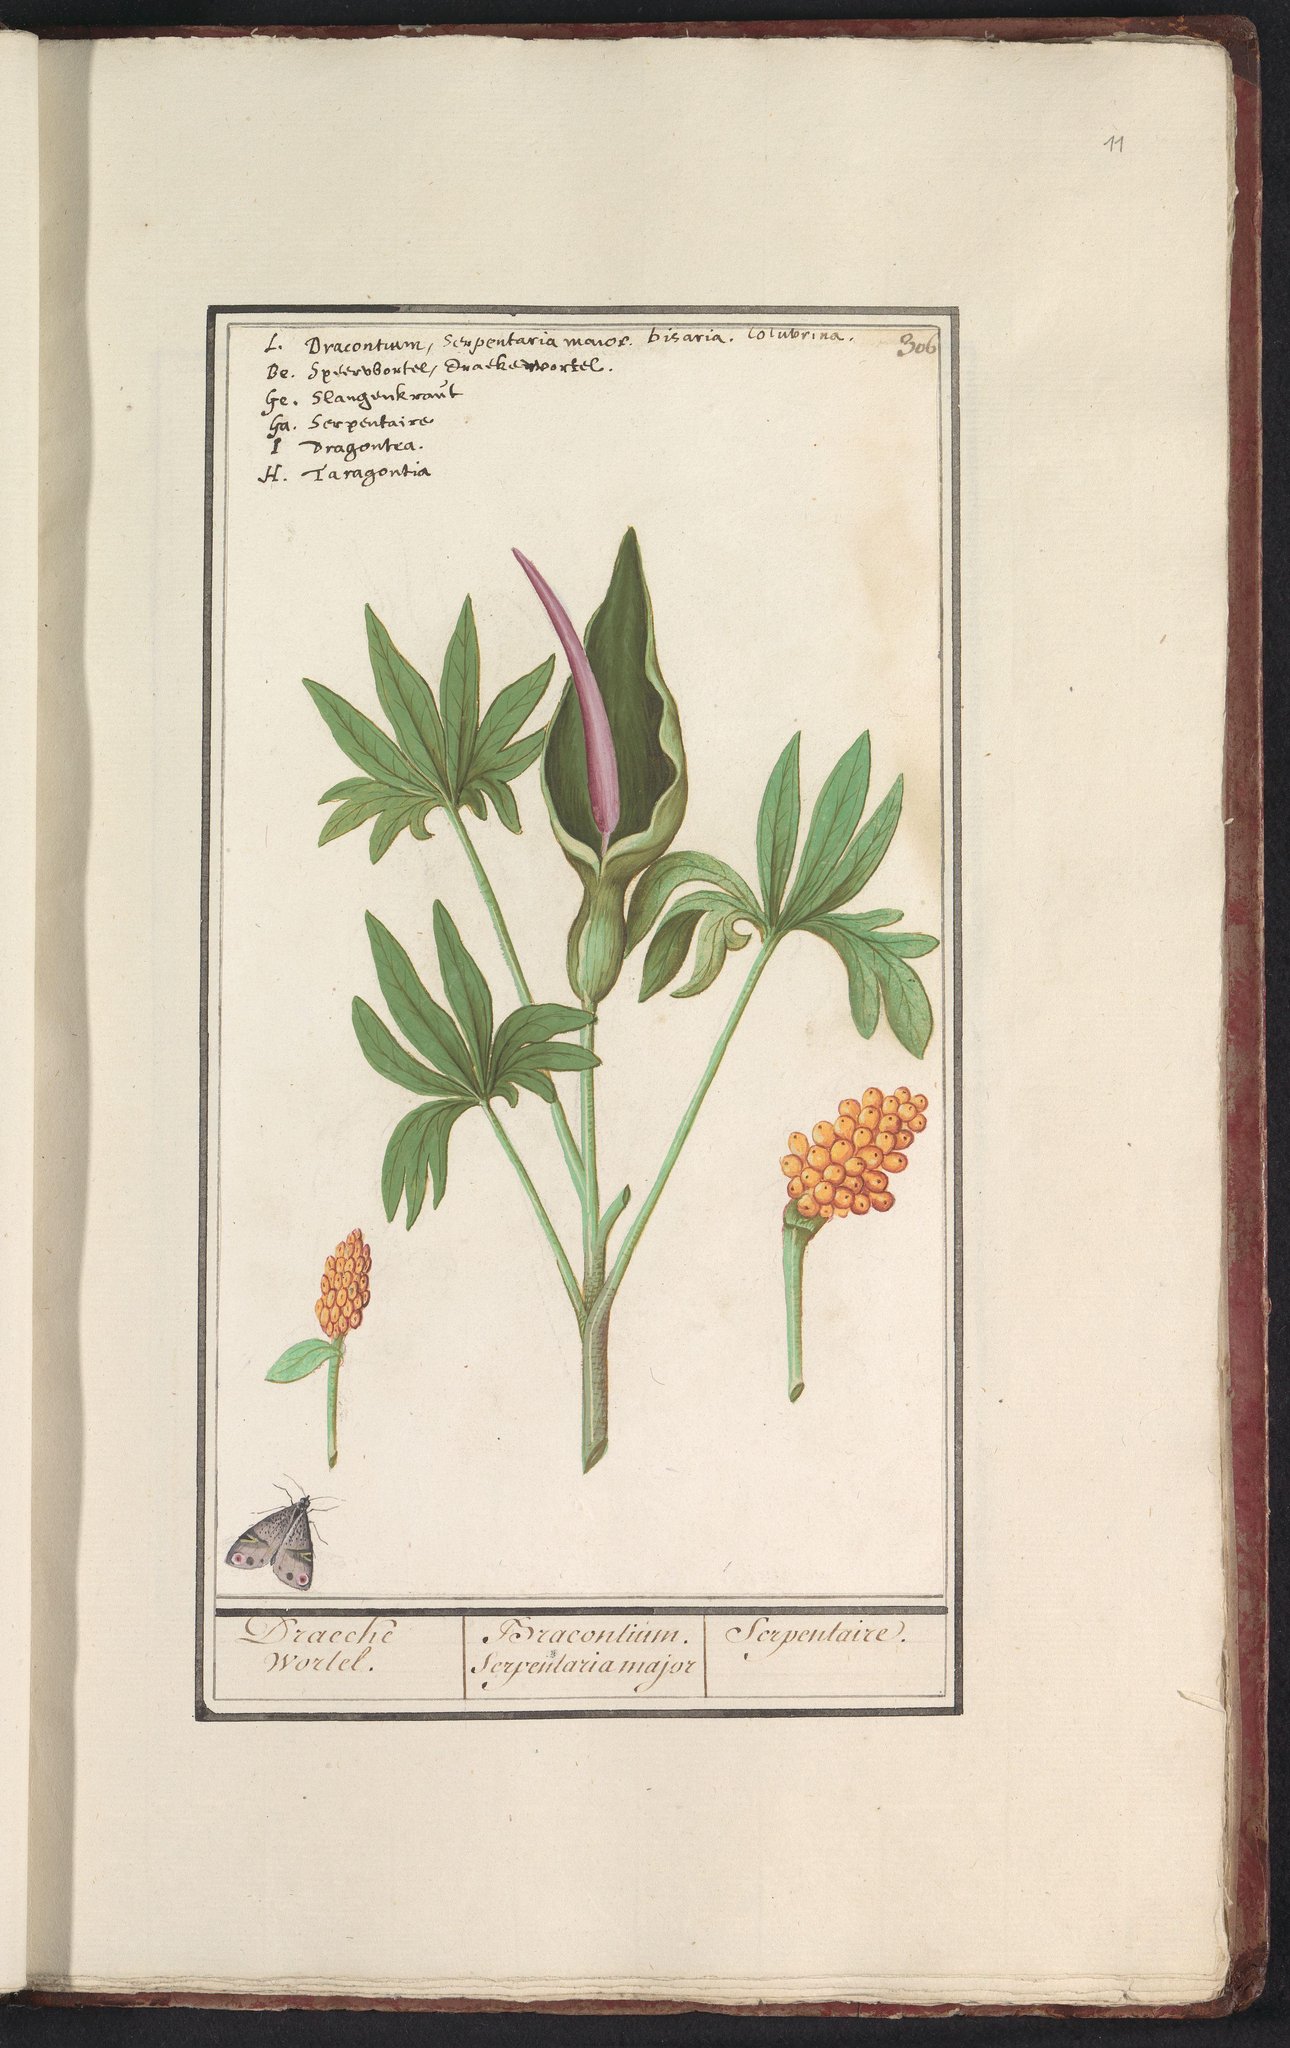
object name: drawing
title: Draecke wortel. / Bracontium. Serpentaria major / Serpentaire.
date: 1596-1610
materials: chalk, paint, ink, paper, watercolor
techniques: brush, pen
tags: flowers: arum, flowers: dracunculus, insects: butterfly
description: Aronskelk, mogelijk drakenwortel. Met een vlinder. Genummerd rechtsboven: 306. Linksboven de naam in zes talen. Onderdeel van het vierde album met tekeningen van bloemen en paddestoelen. Elfde van twaalf albums met tekeningen van dieren, vogels en planten bekend rond 1600, gemaakt in opdracht van keizer Rudolf II. Met toelichting in Nederlands, Latijn en Frans.